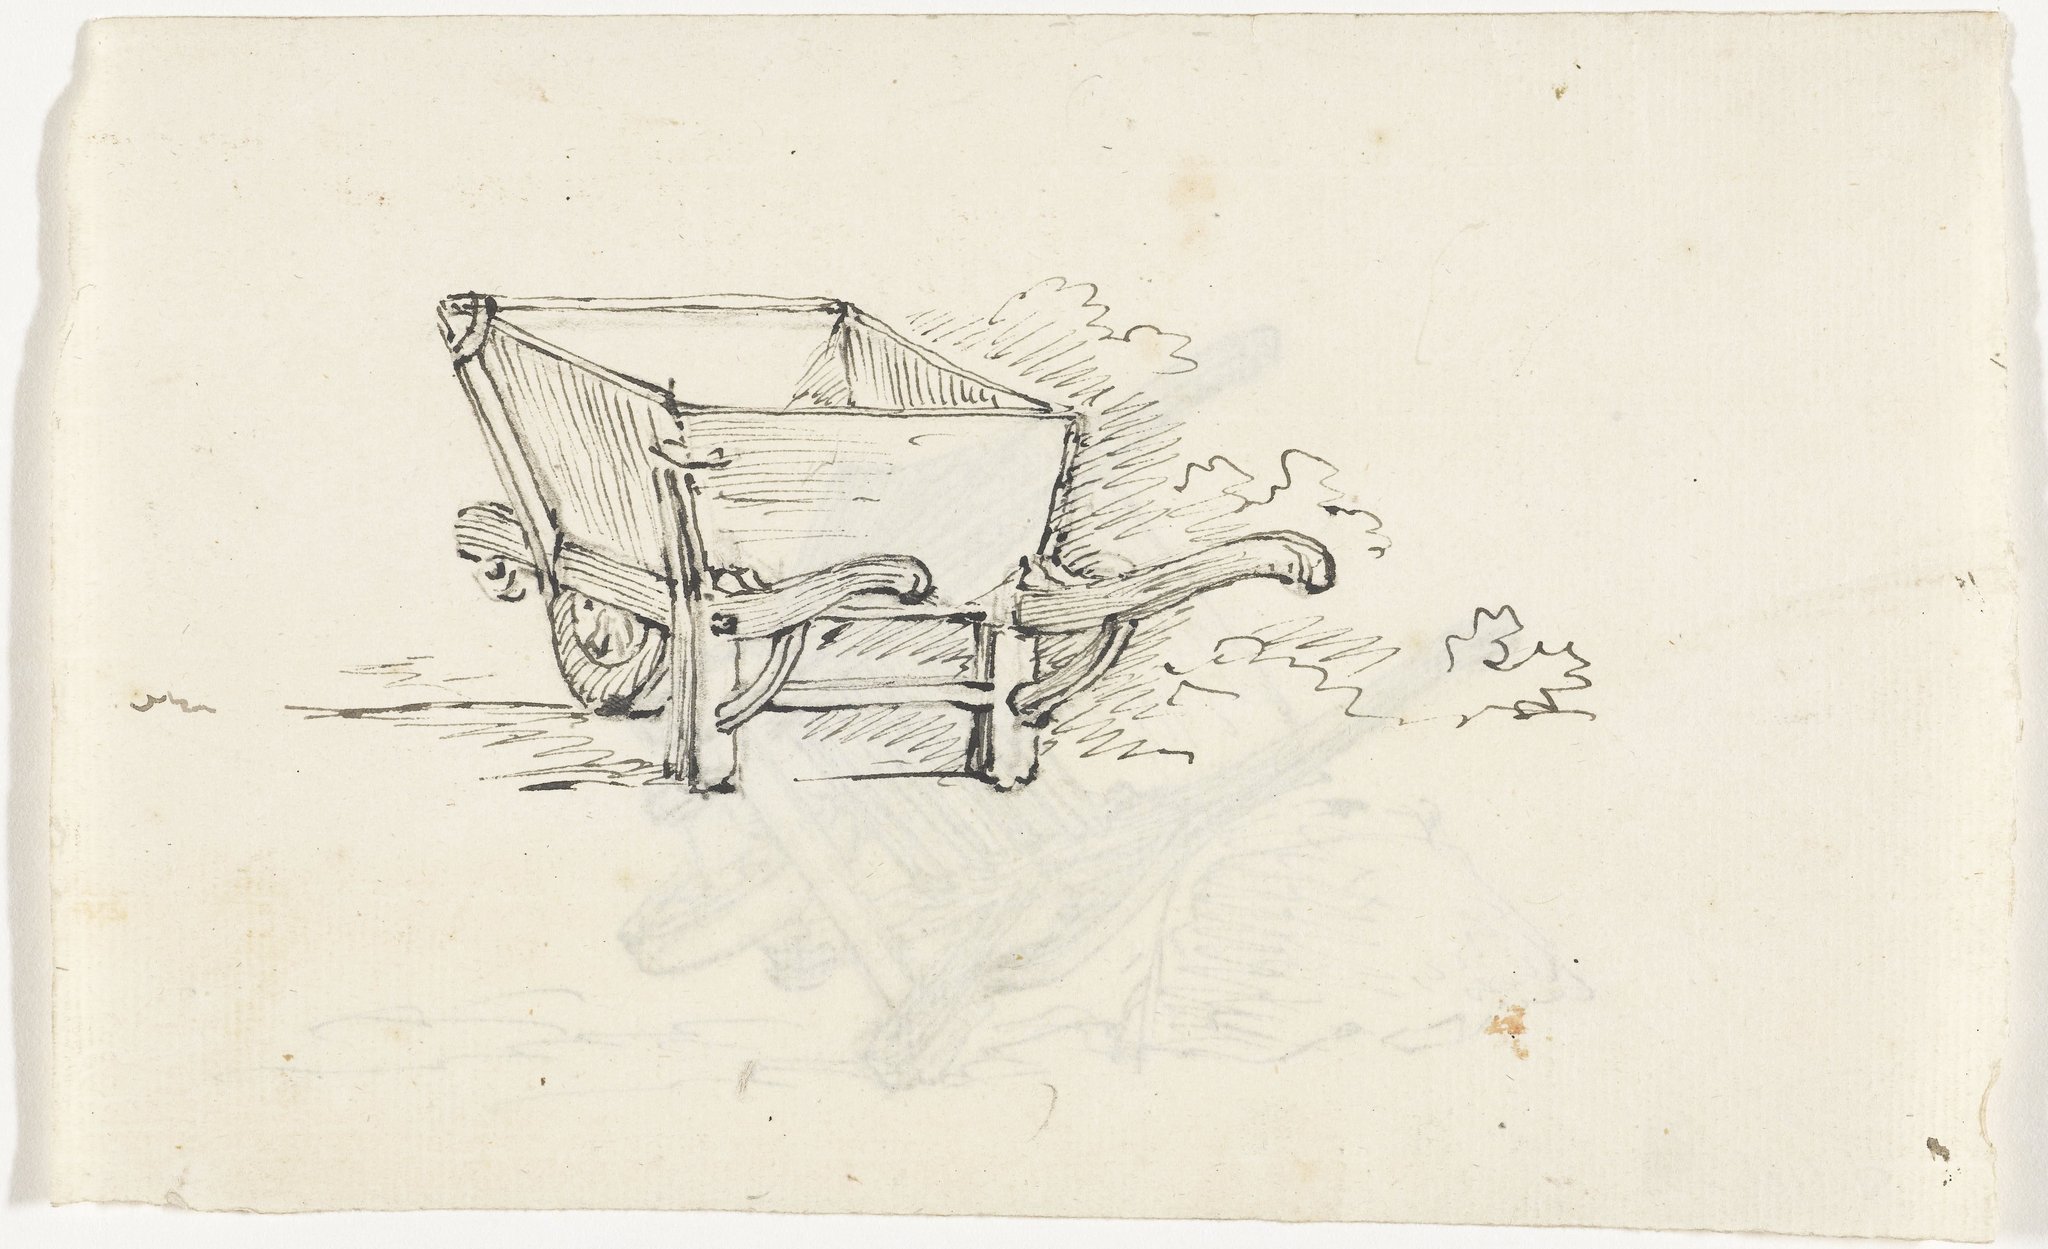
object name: drawing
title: Kruiwagen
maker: pieter bartholomeusz. barbiers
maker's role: draughtsman, print maker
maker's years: 1772-1837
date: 1782-1837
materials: graphite, ink, paper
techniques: pen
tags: wheelbarrow